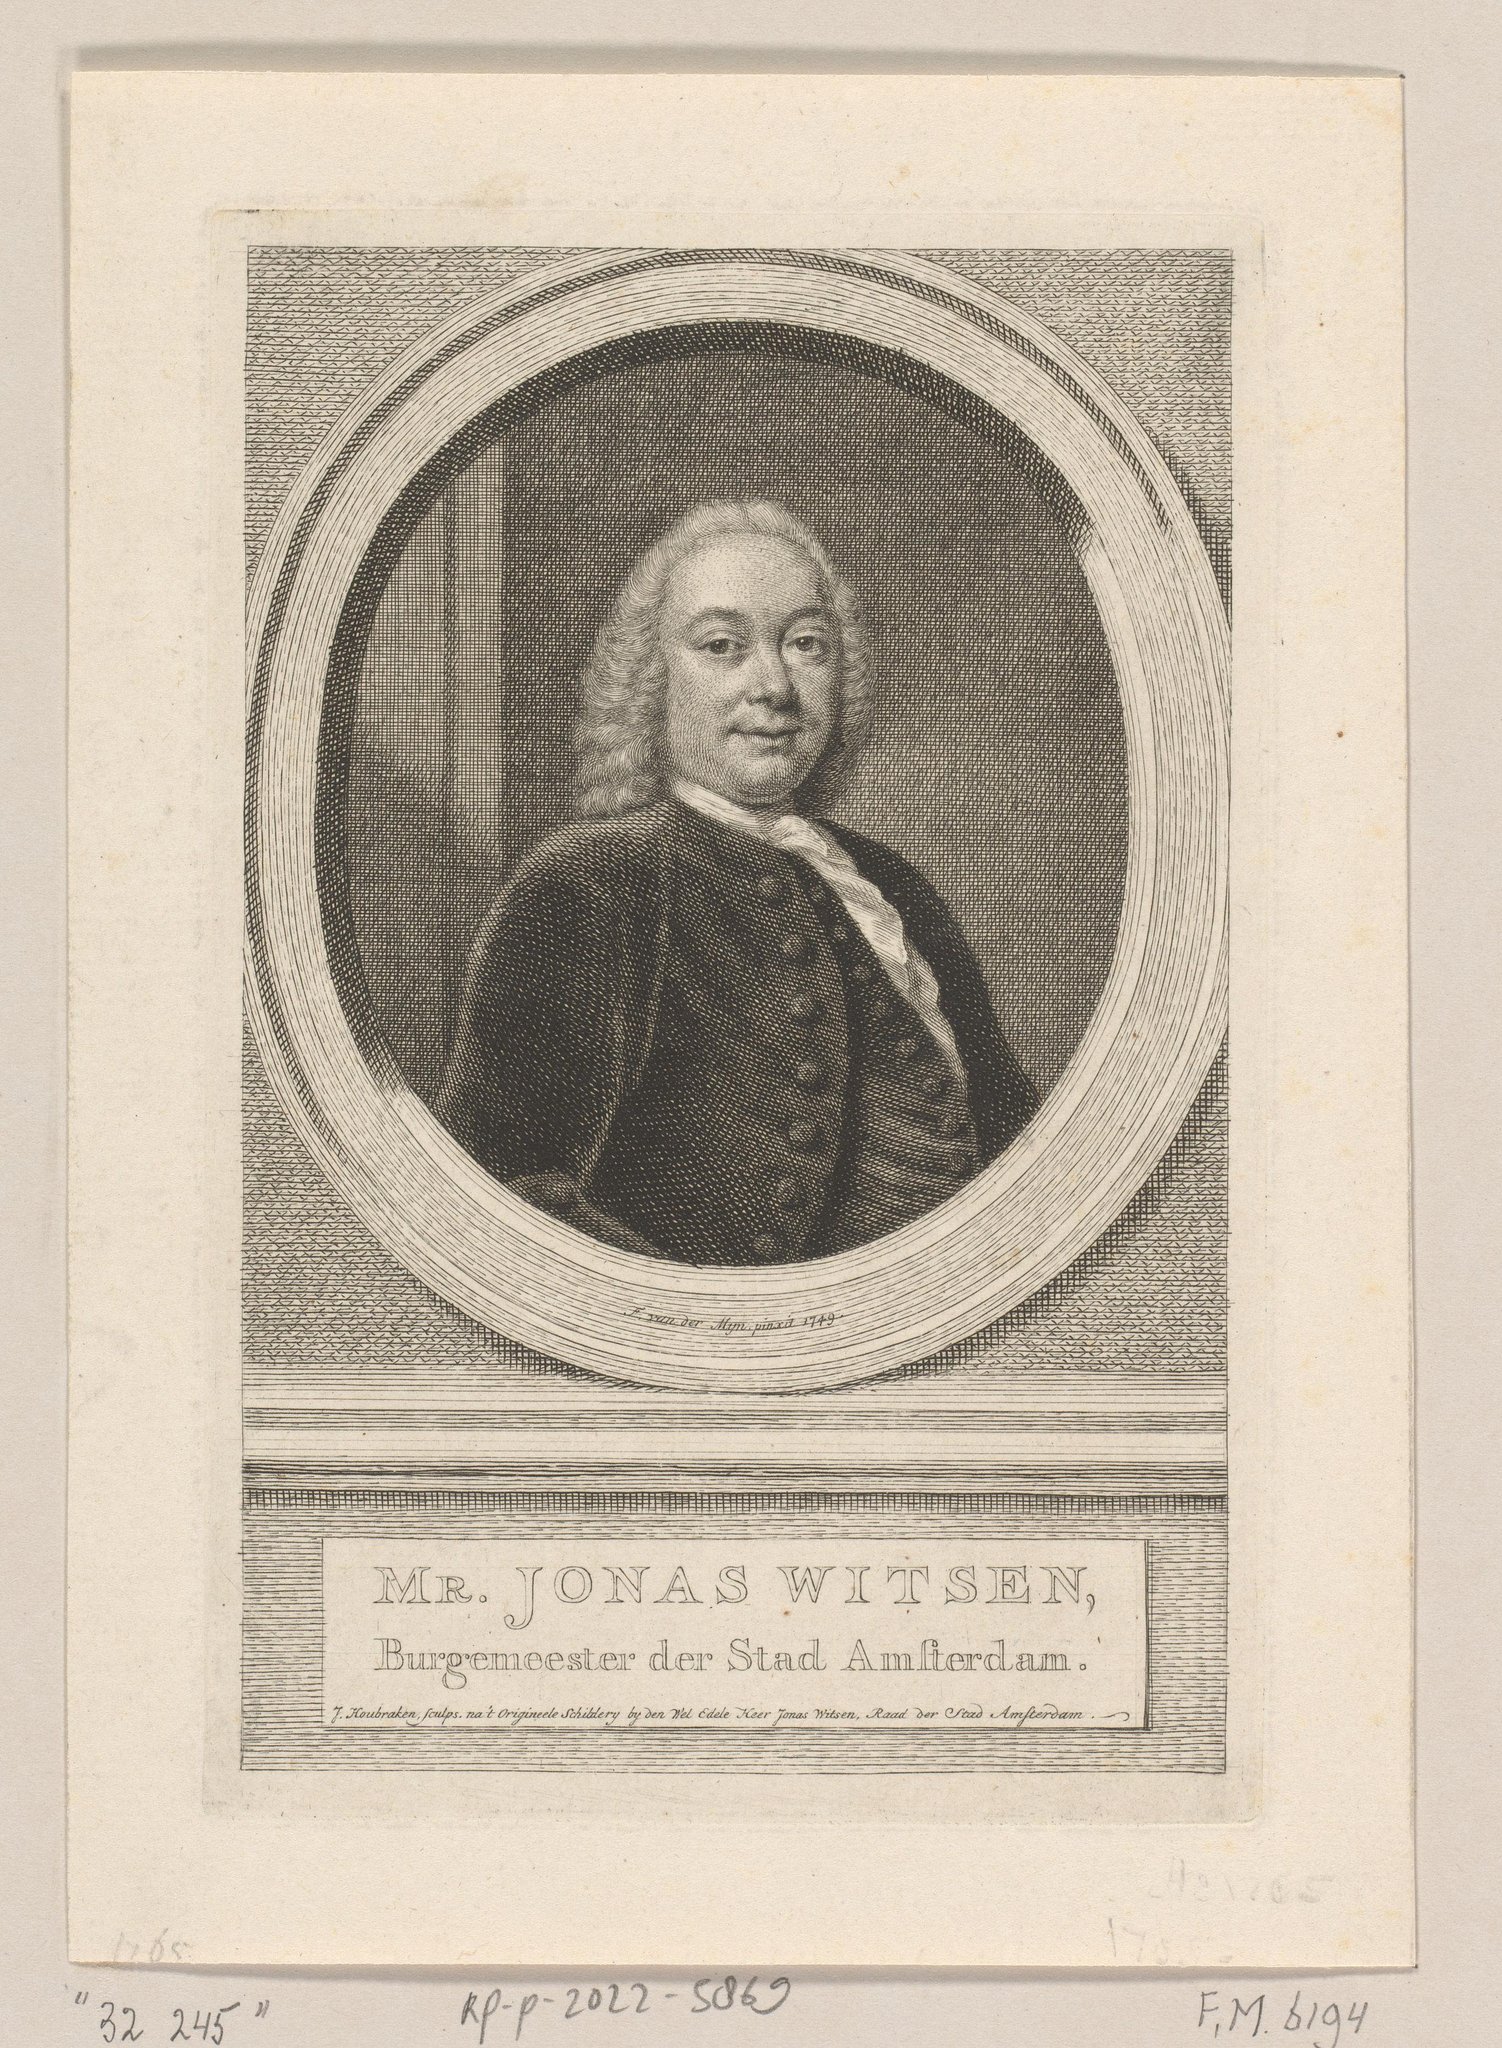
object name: print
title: Portret van Jonas Witsen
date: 1749-1767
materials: paper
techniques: engraving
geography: amsterdam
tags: amsterdam, print maker, mayor, jonas witsen, mayor, burgomaster, historical persons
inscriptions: number: ‘32 245’